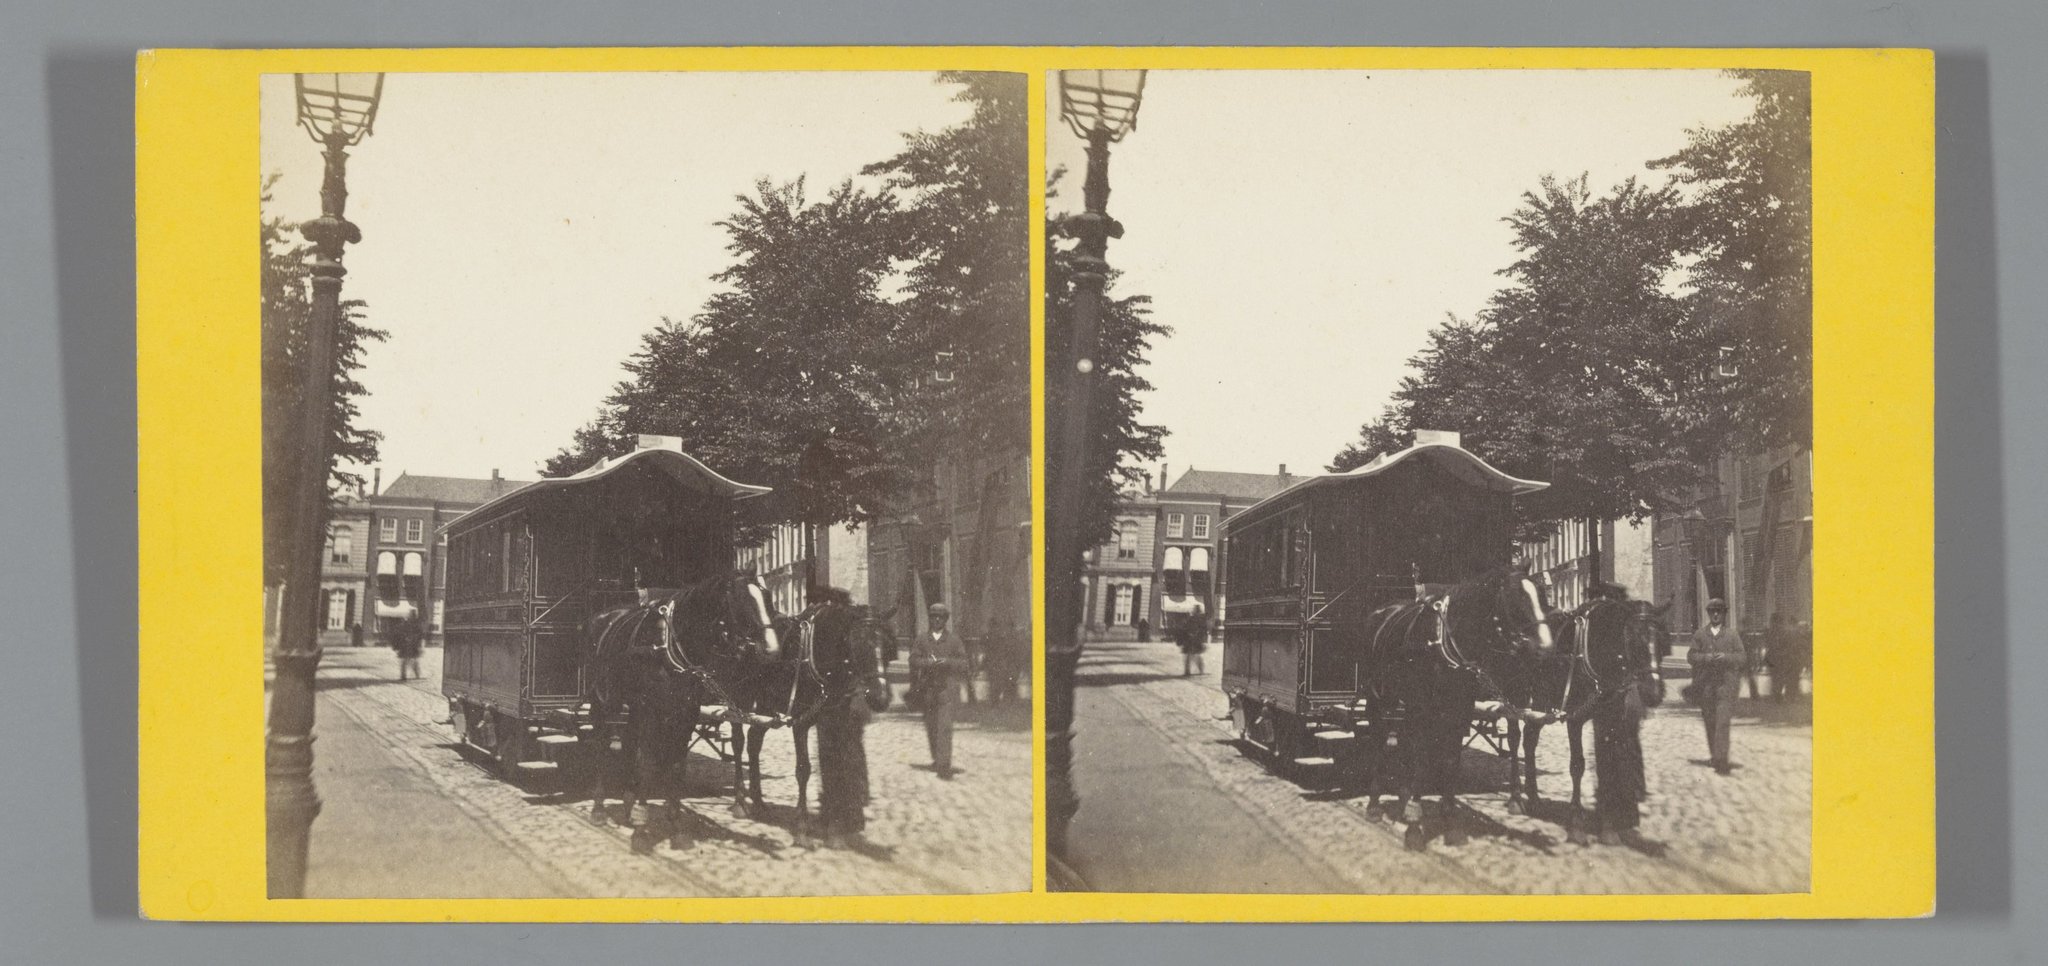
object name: stereograph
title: Paardentram op de Kneuterdijk in Den Haag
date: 1860-1885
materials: cardboard, photographic support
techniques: albumen print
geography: the hague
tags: horse, four-wheeled vehicle drawn by two animals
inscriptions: inscription: ‘DE KNEUTERDIJK/ TE/ 's Gravenhage./ A. JAGER, WATER 100, TE AMSTERDAM.’, annotation: ‘ook in album [...] Holland’